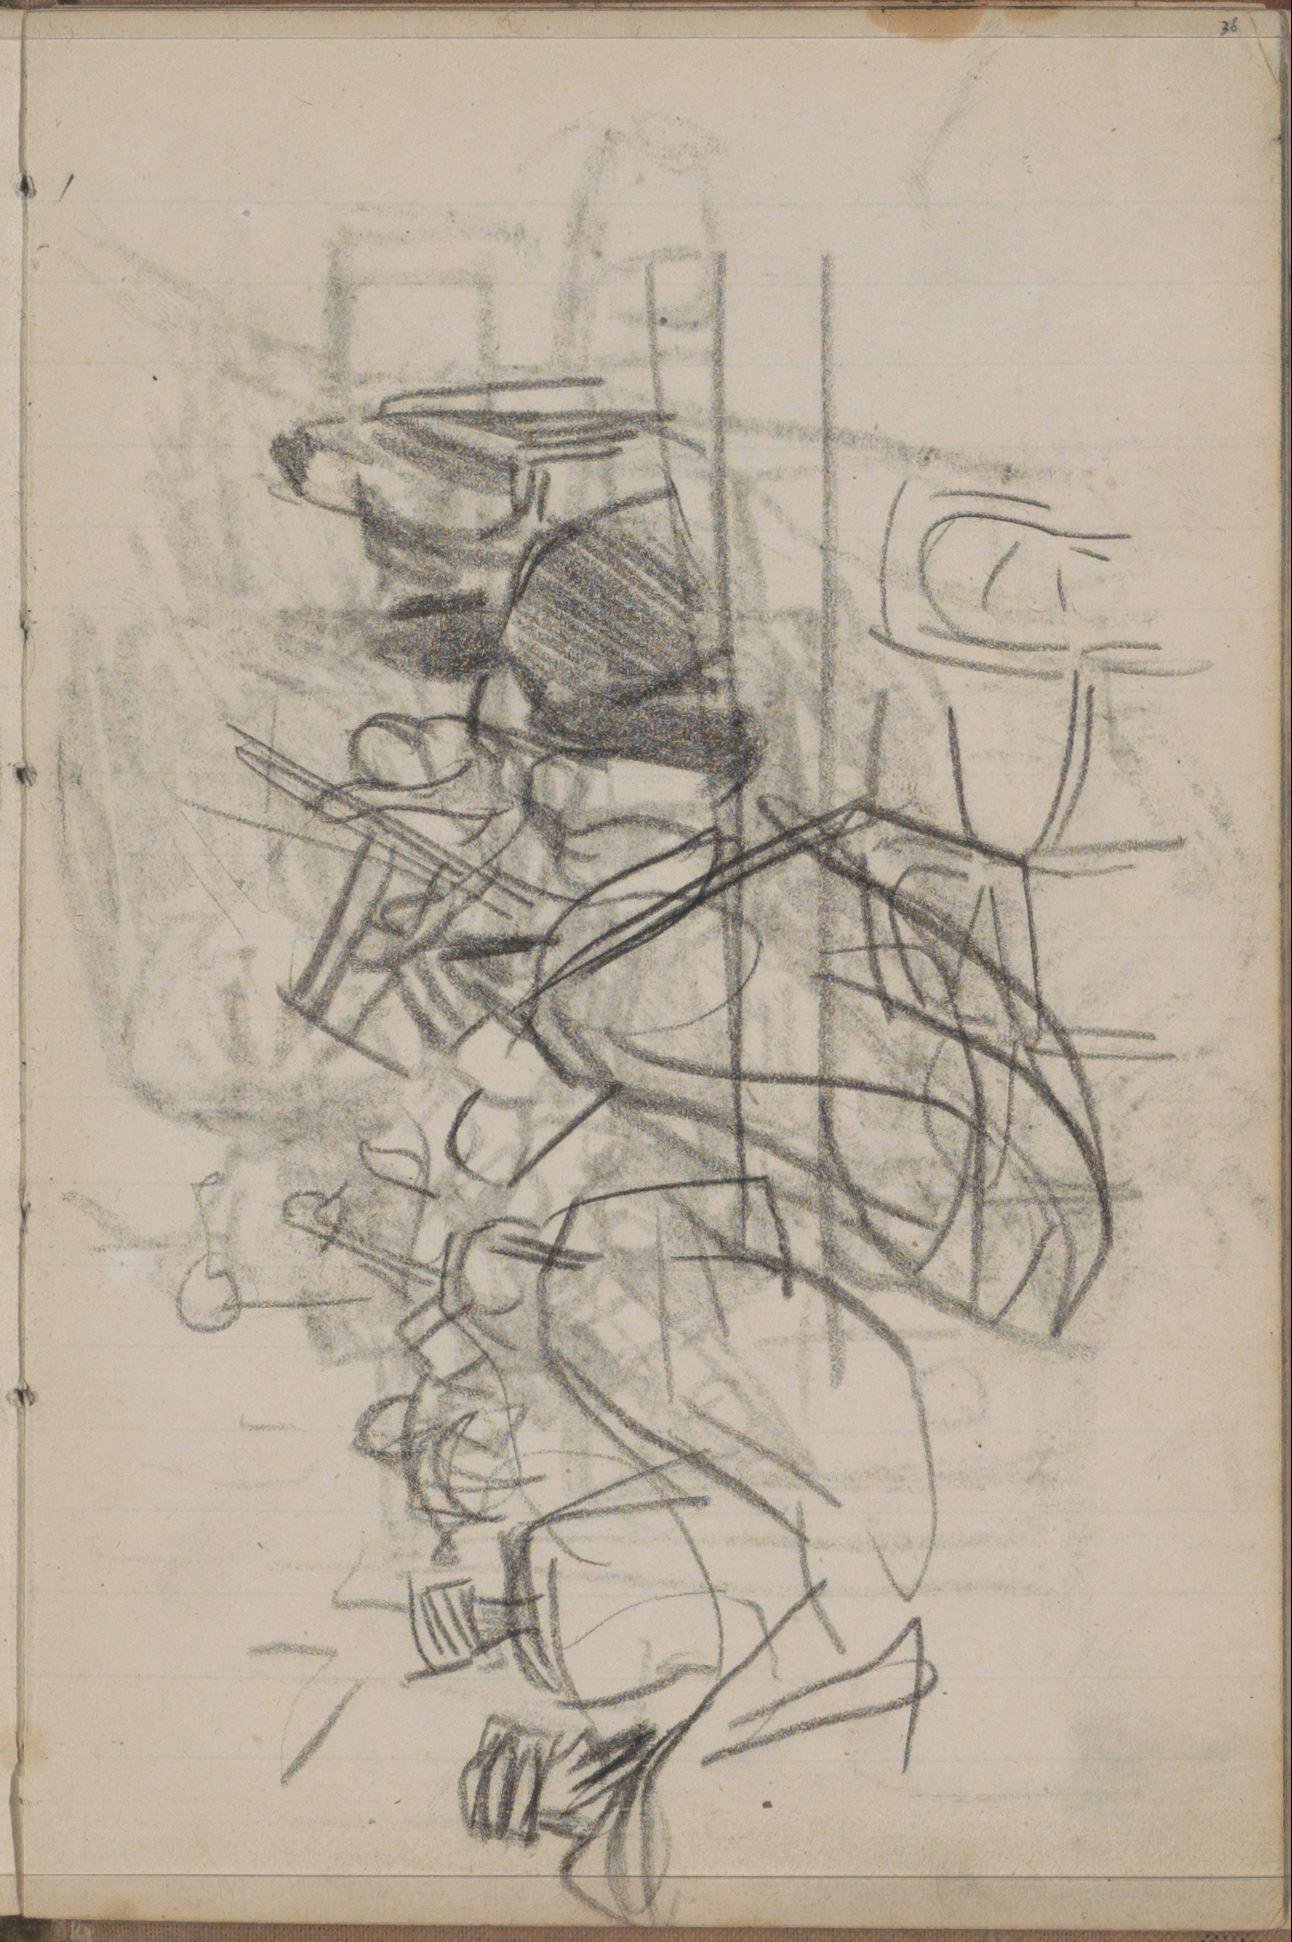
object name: sketchbook leaf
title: Groep figuren, mogelijk in een café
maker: marius bauer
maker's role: draughtsman, print maker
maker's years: 1867-1932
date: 1888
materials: chalk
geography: istanbul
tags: asiatic races and peoples, inn, coffee-house, public house, etc.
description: Op de voorgrond twee stoelen. Pagina 36 uit een schetsboek met 58 bladen.